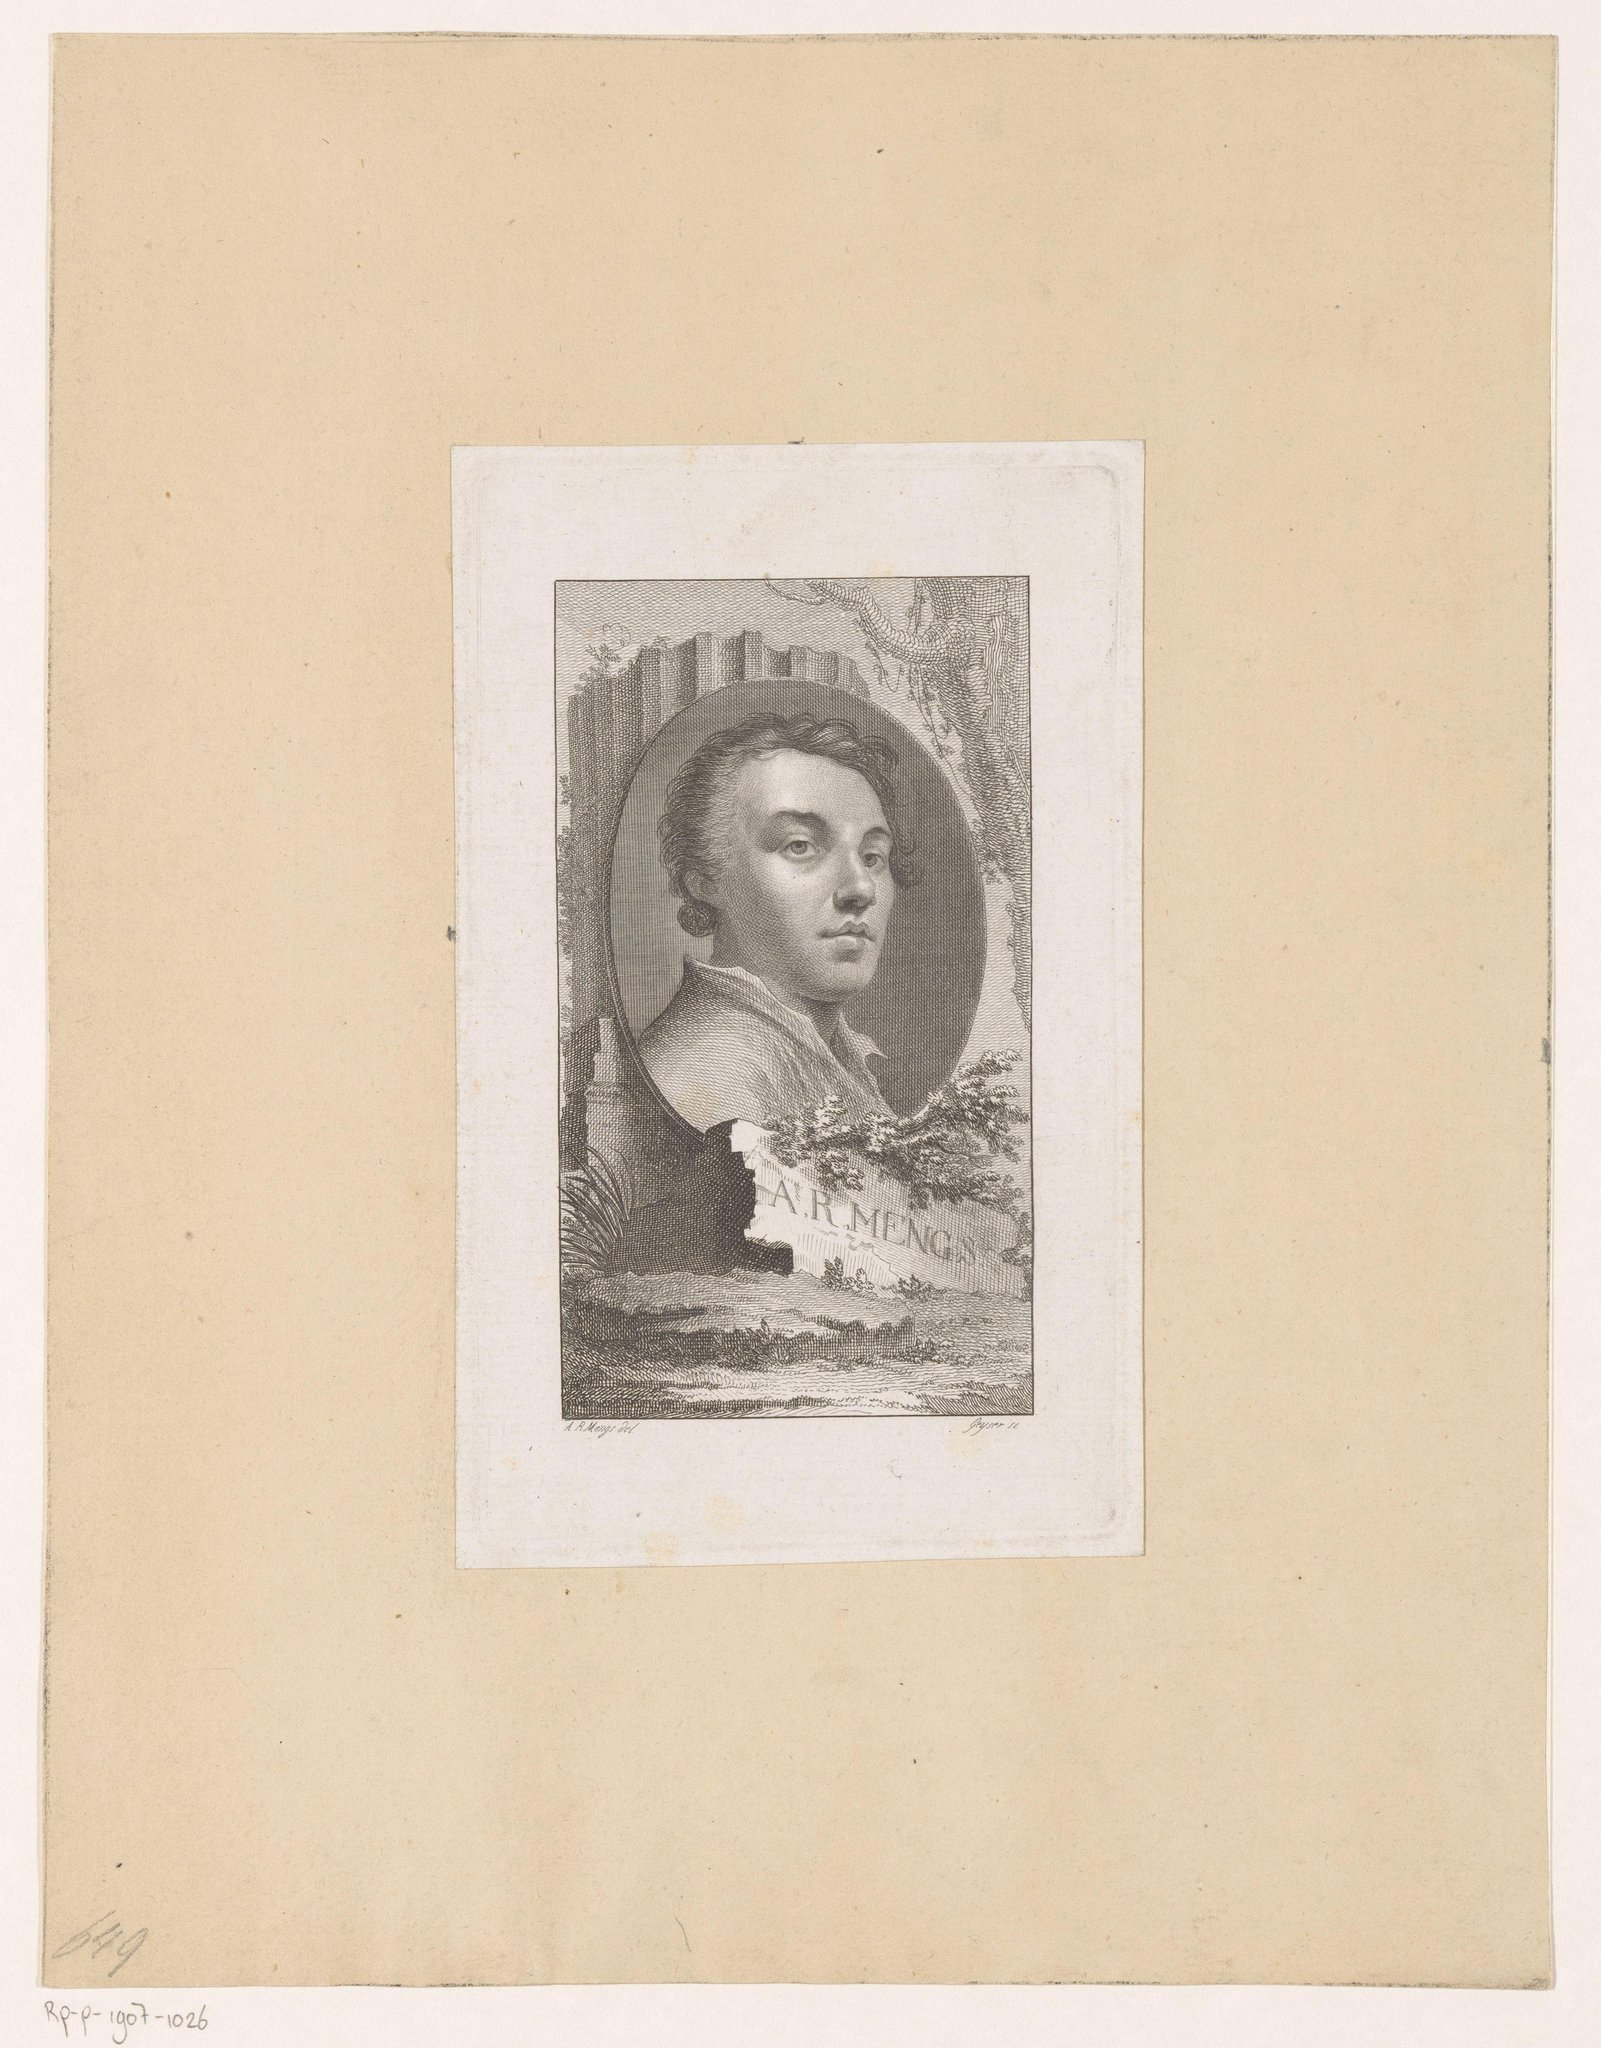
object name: print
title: Portret van Anton Raphael Mengs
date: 1752-1803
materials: paper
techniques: engraving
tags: rome, painter, draughtsman, anton raphael mengs, plants; vegetation, historical persons, base (~ column, pillar)